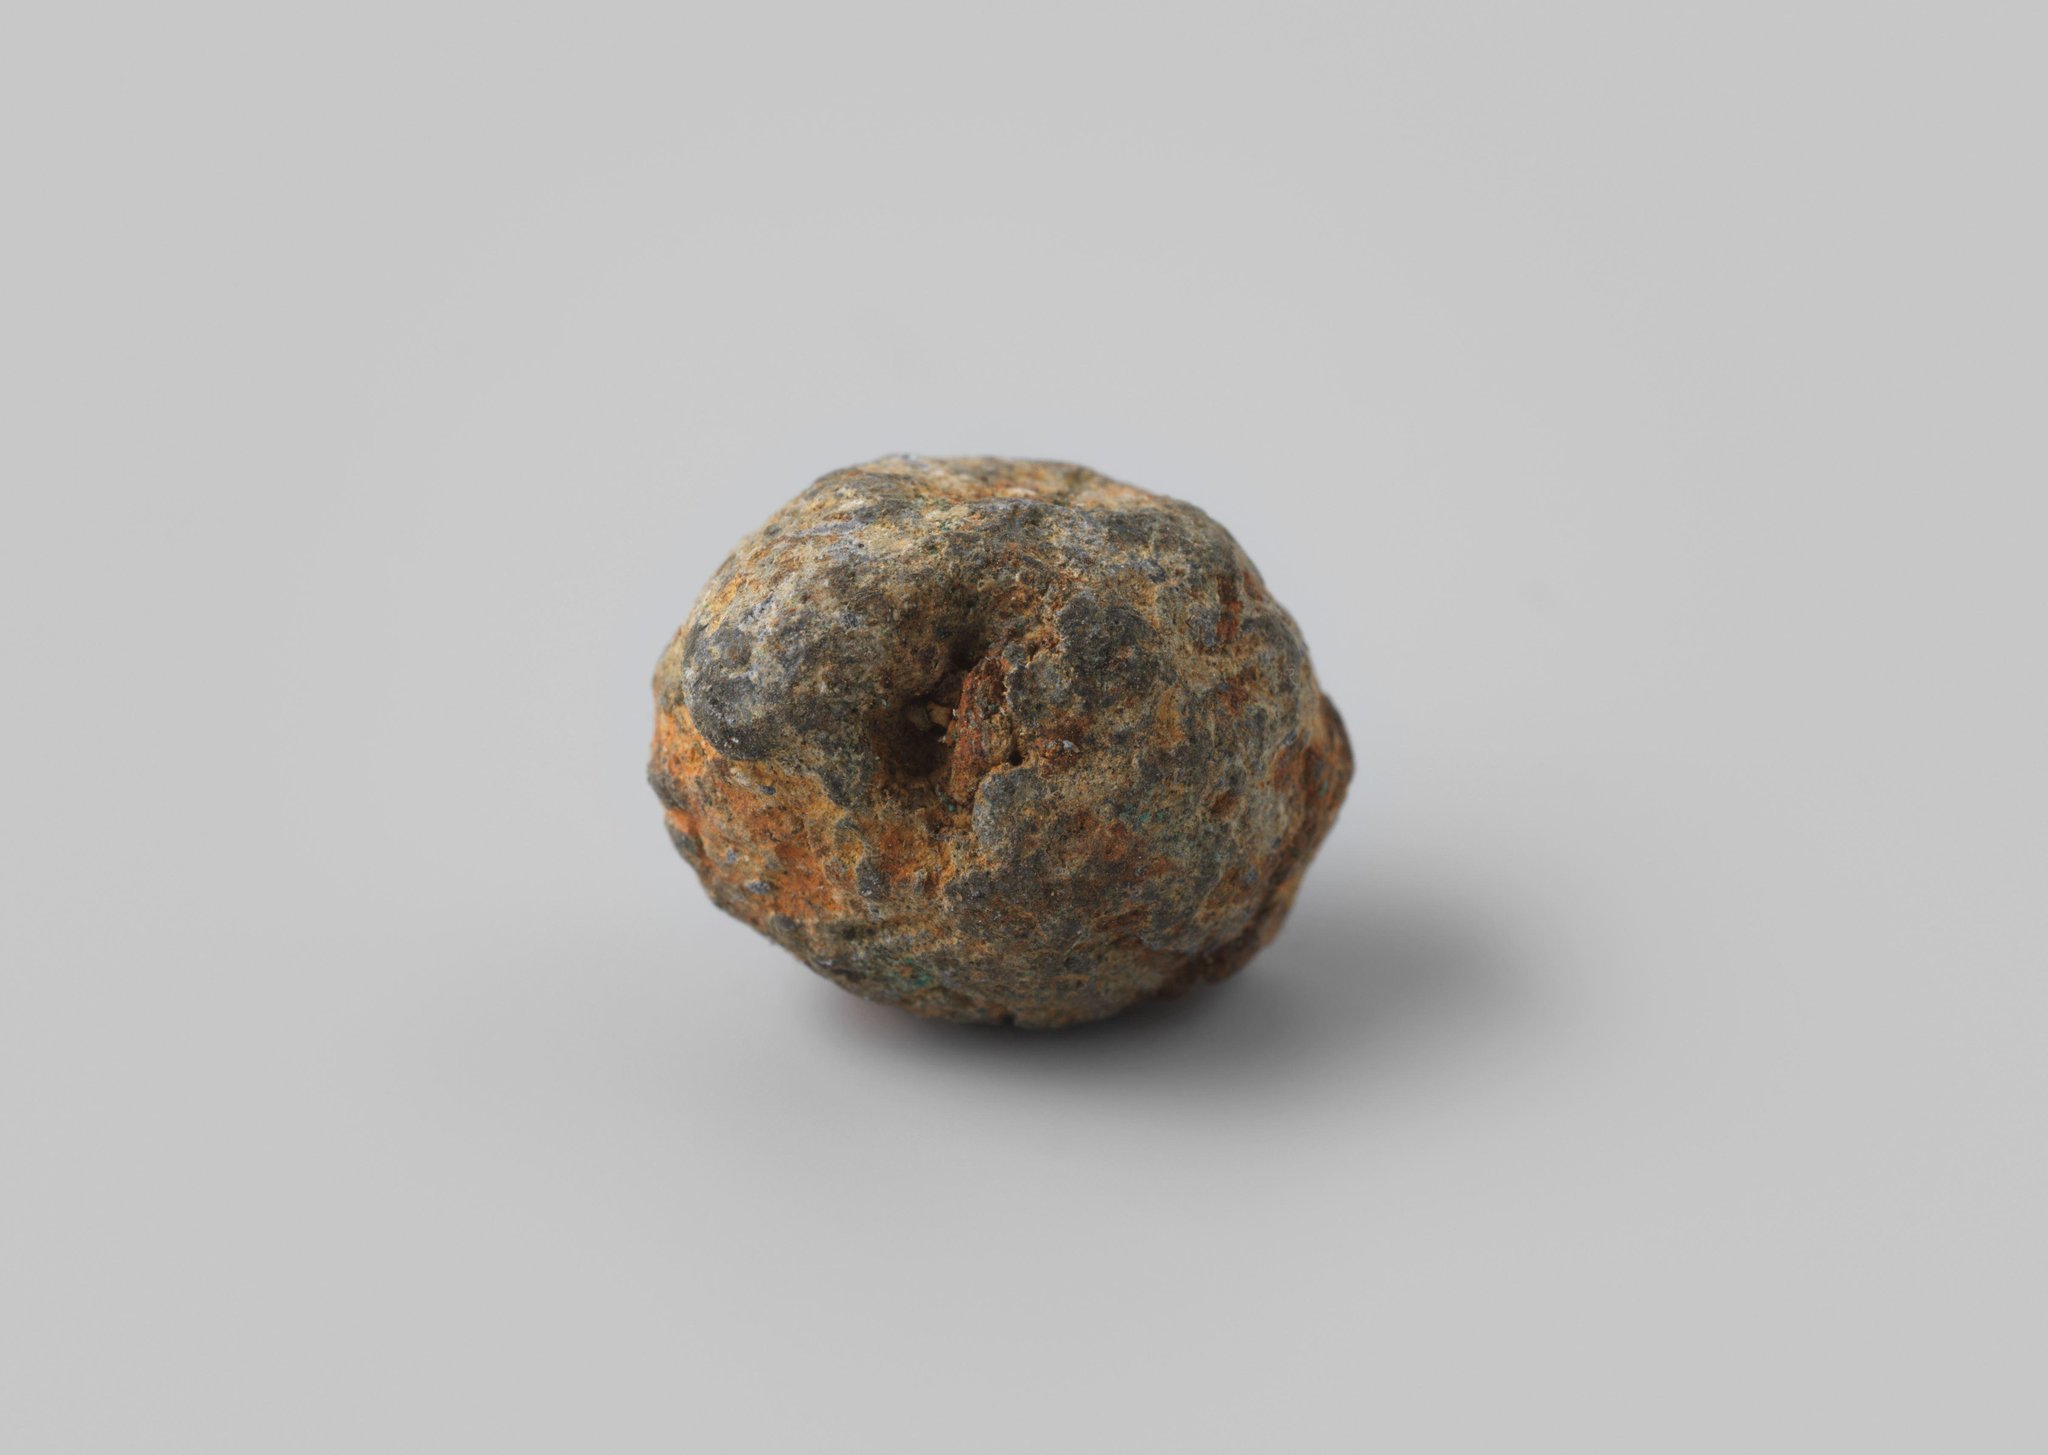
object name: musketkogel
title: Musketkogel uit het wrak van de Oost-Indiëvaarder Hollandia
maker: Anonymous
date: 1700-1743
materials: lead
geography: netherlands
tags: verenigde oostindische compagnie, hollandia (schip), annet